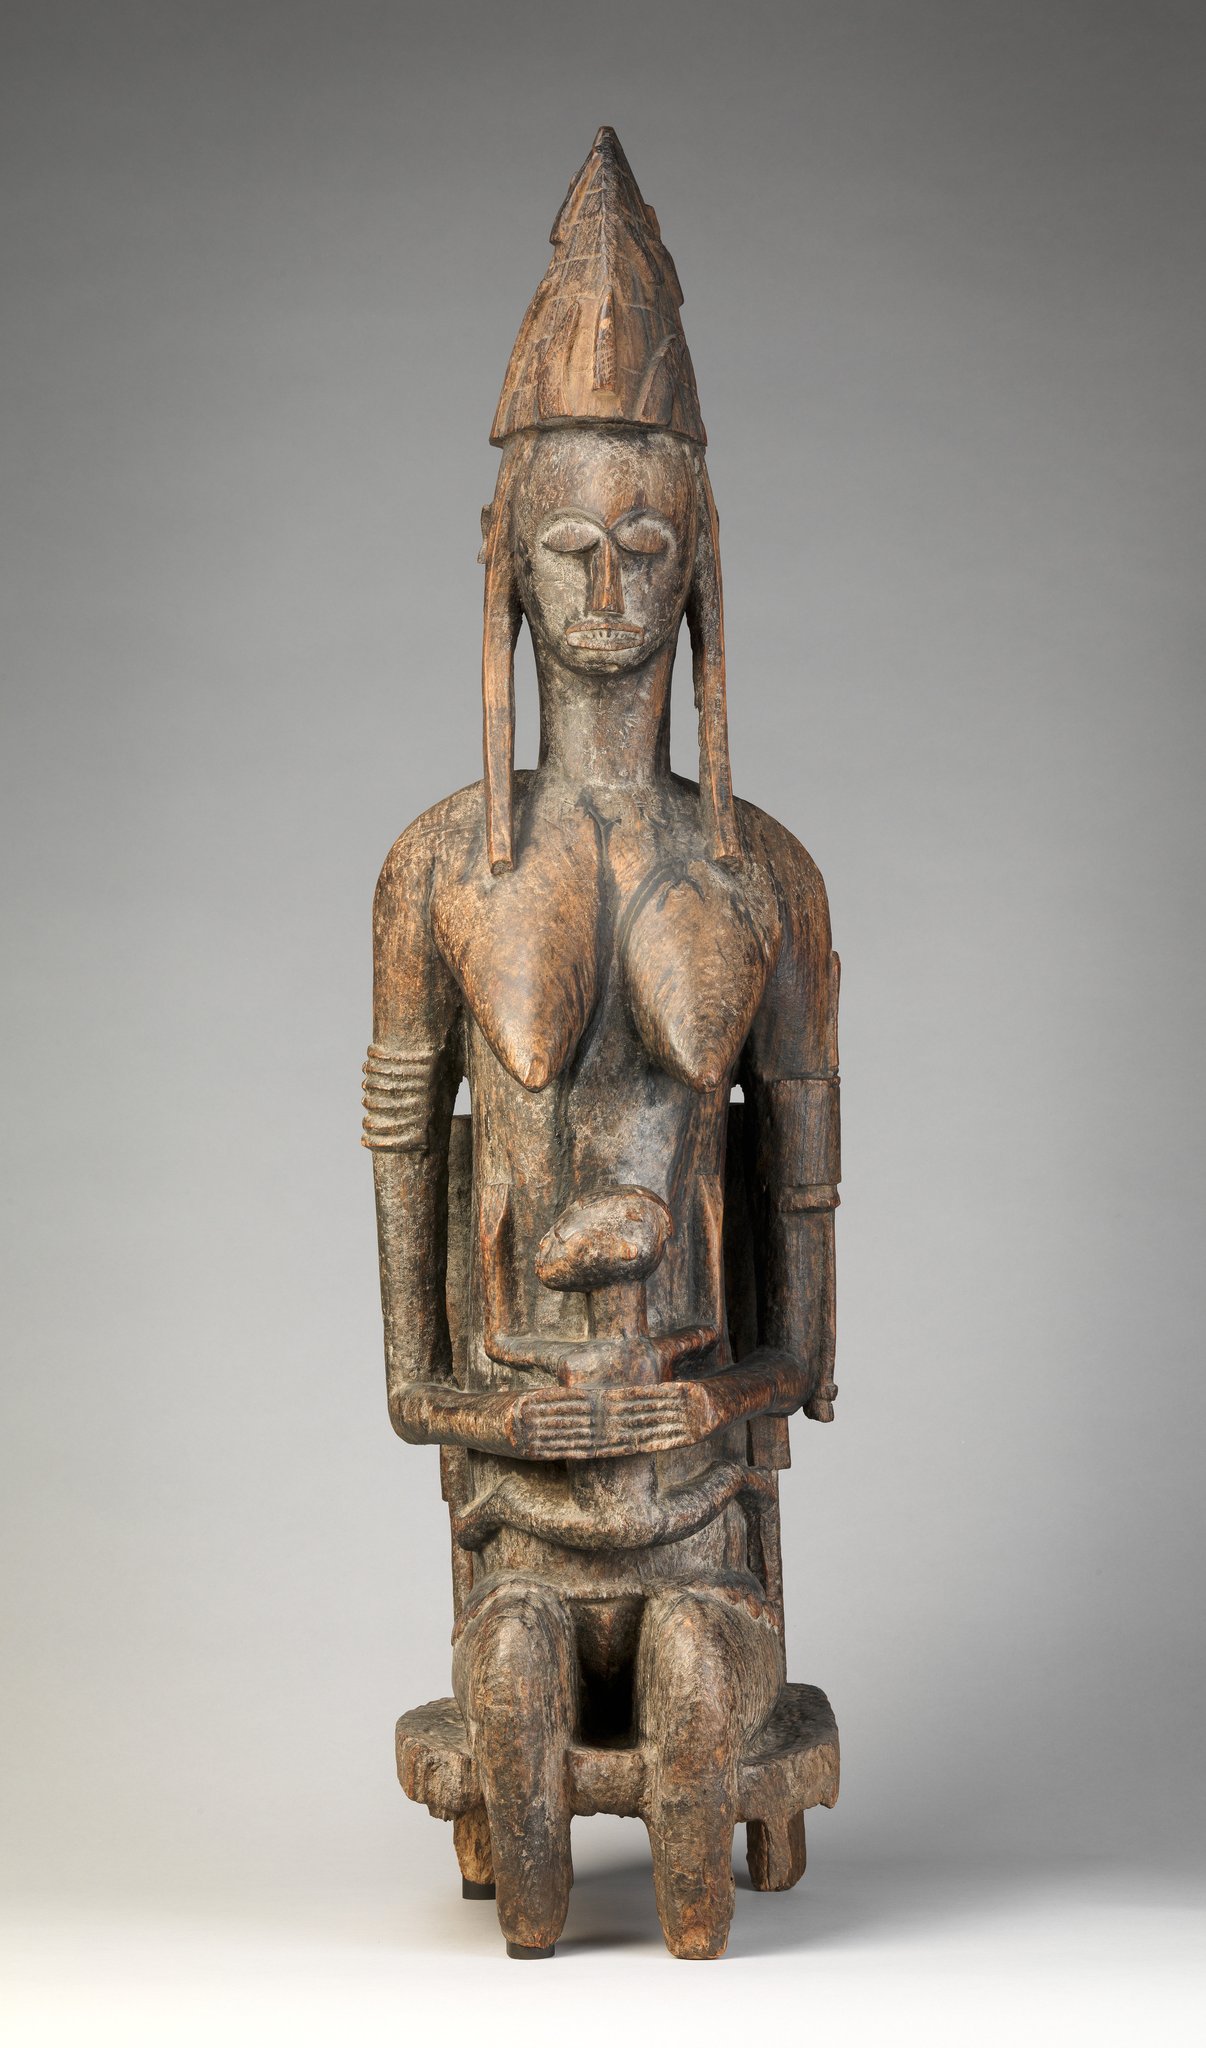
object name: figure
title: Gwandusu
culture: bamana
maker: bamana numu (blacksmith)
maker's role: artist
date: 1401-1700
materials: wood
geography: mali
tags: infants,mothers